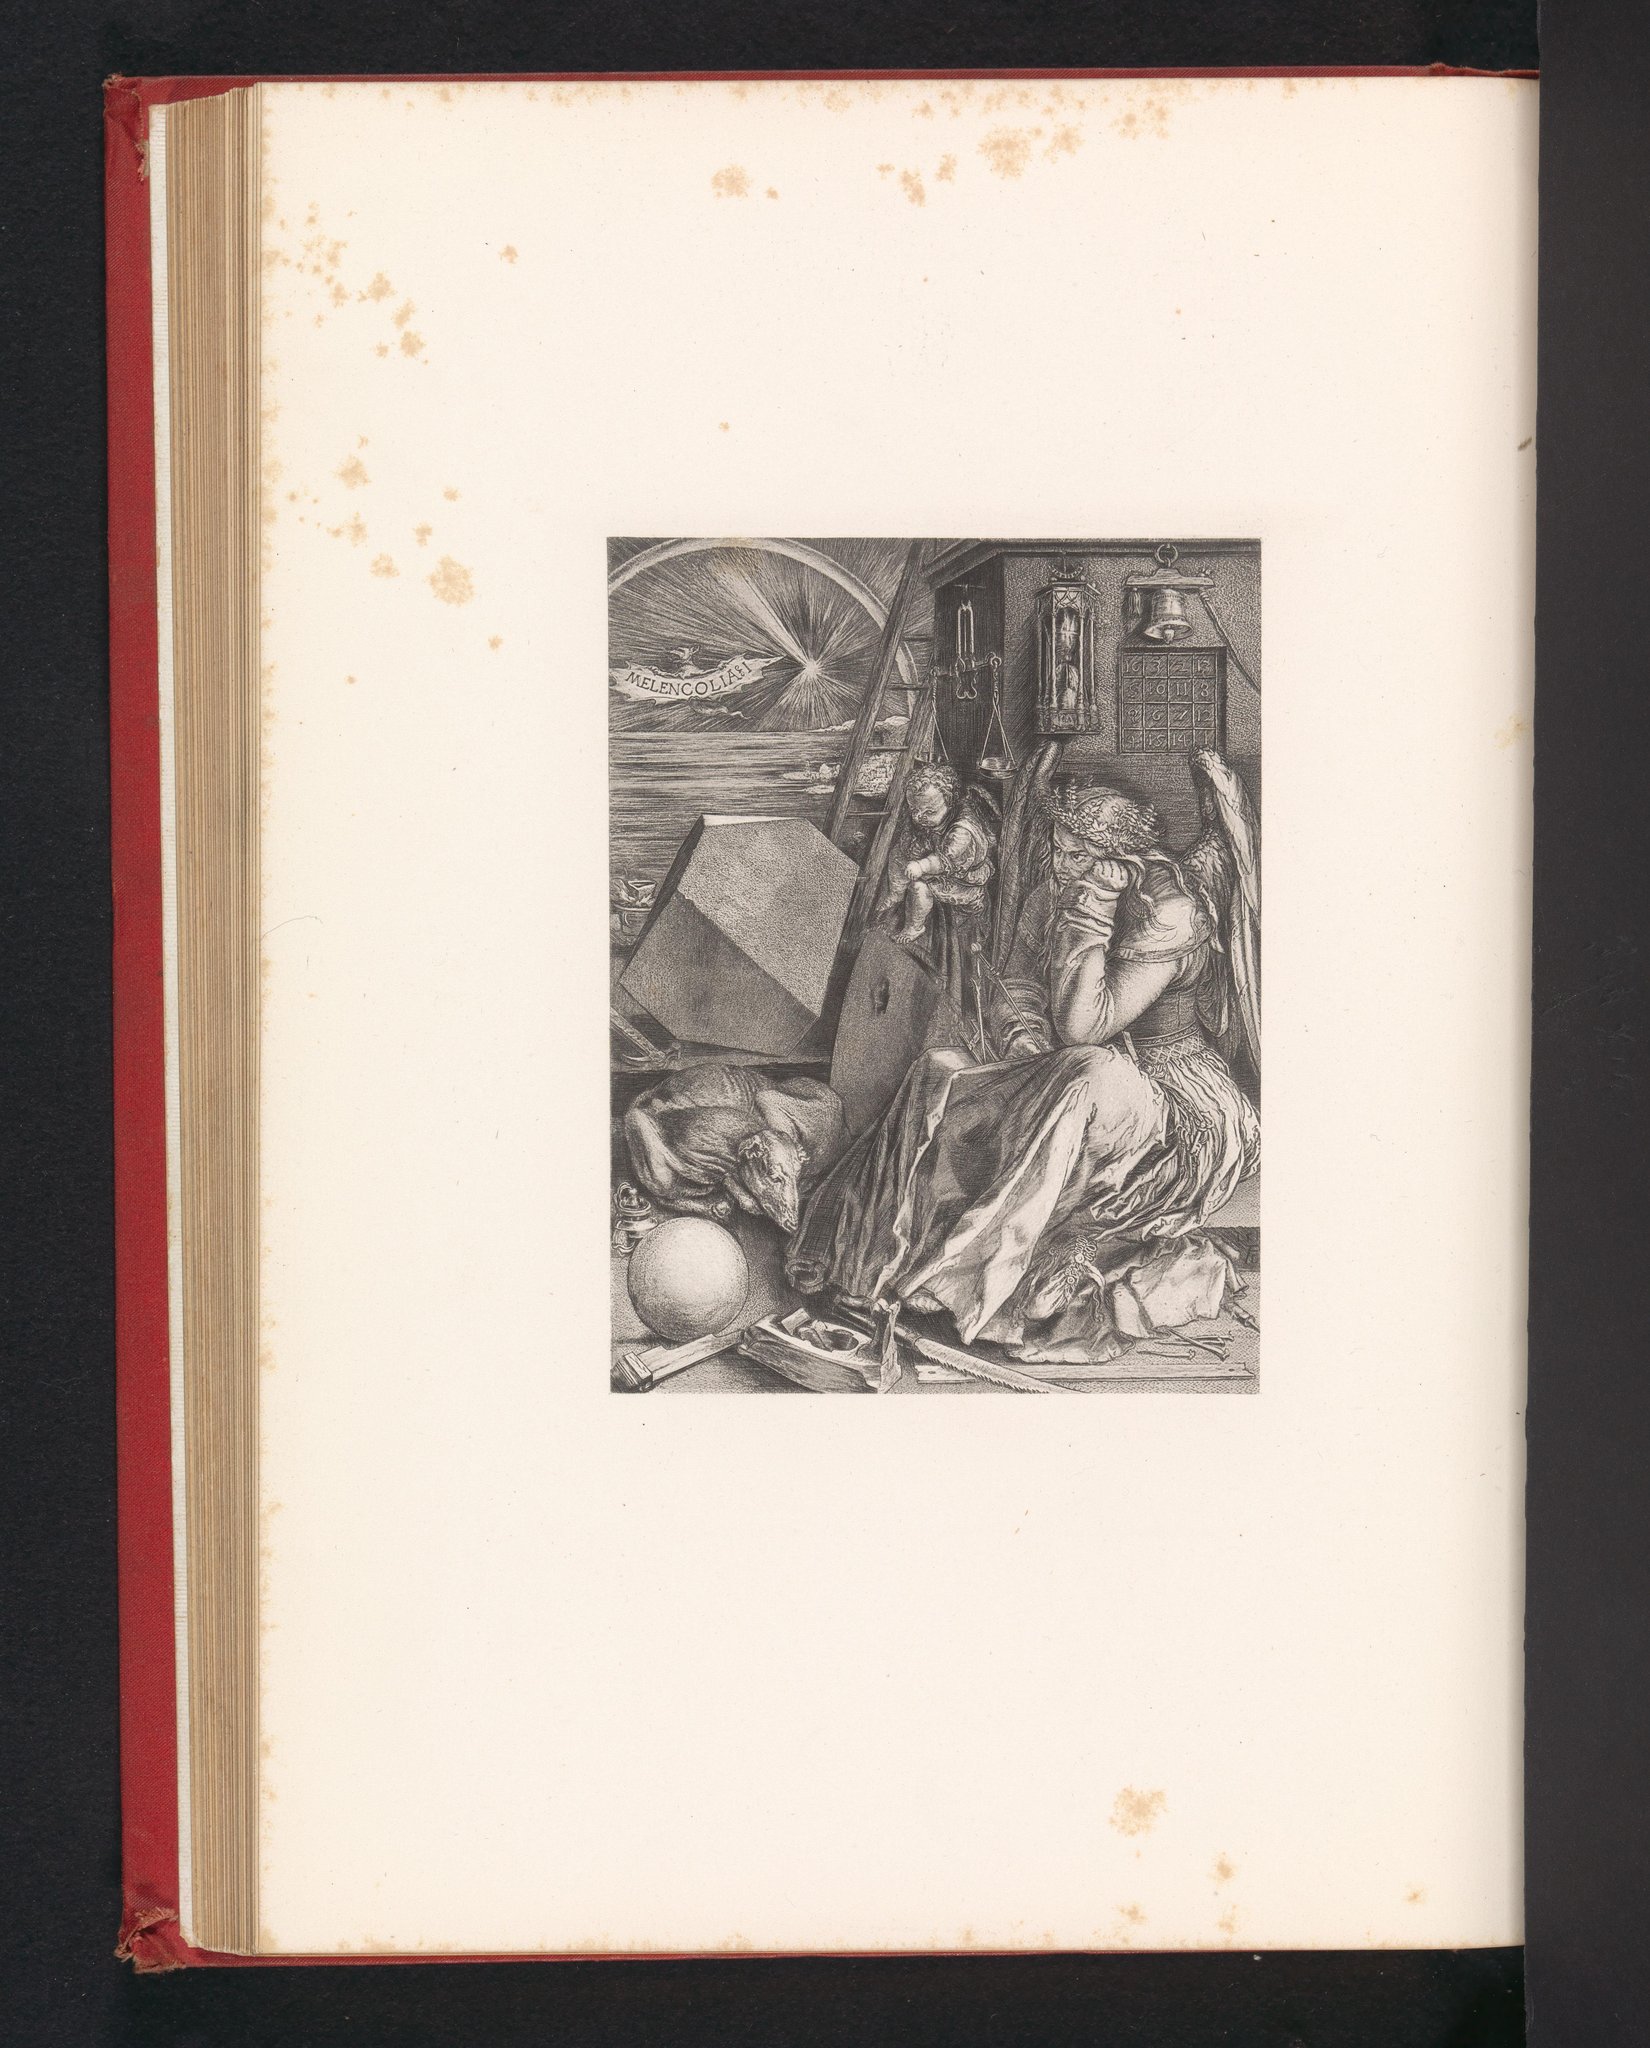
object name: page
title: Melancolia, bu Albrecht Dürer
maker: Anonymous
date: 1878-1888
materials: paper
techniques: photoaquatint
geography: philadelphia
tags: print, e.g.: engraving, etching, lithograph